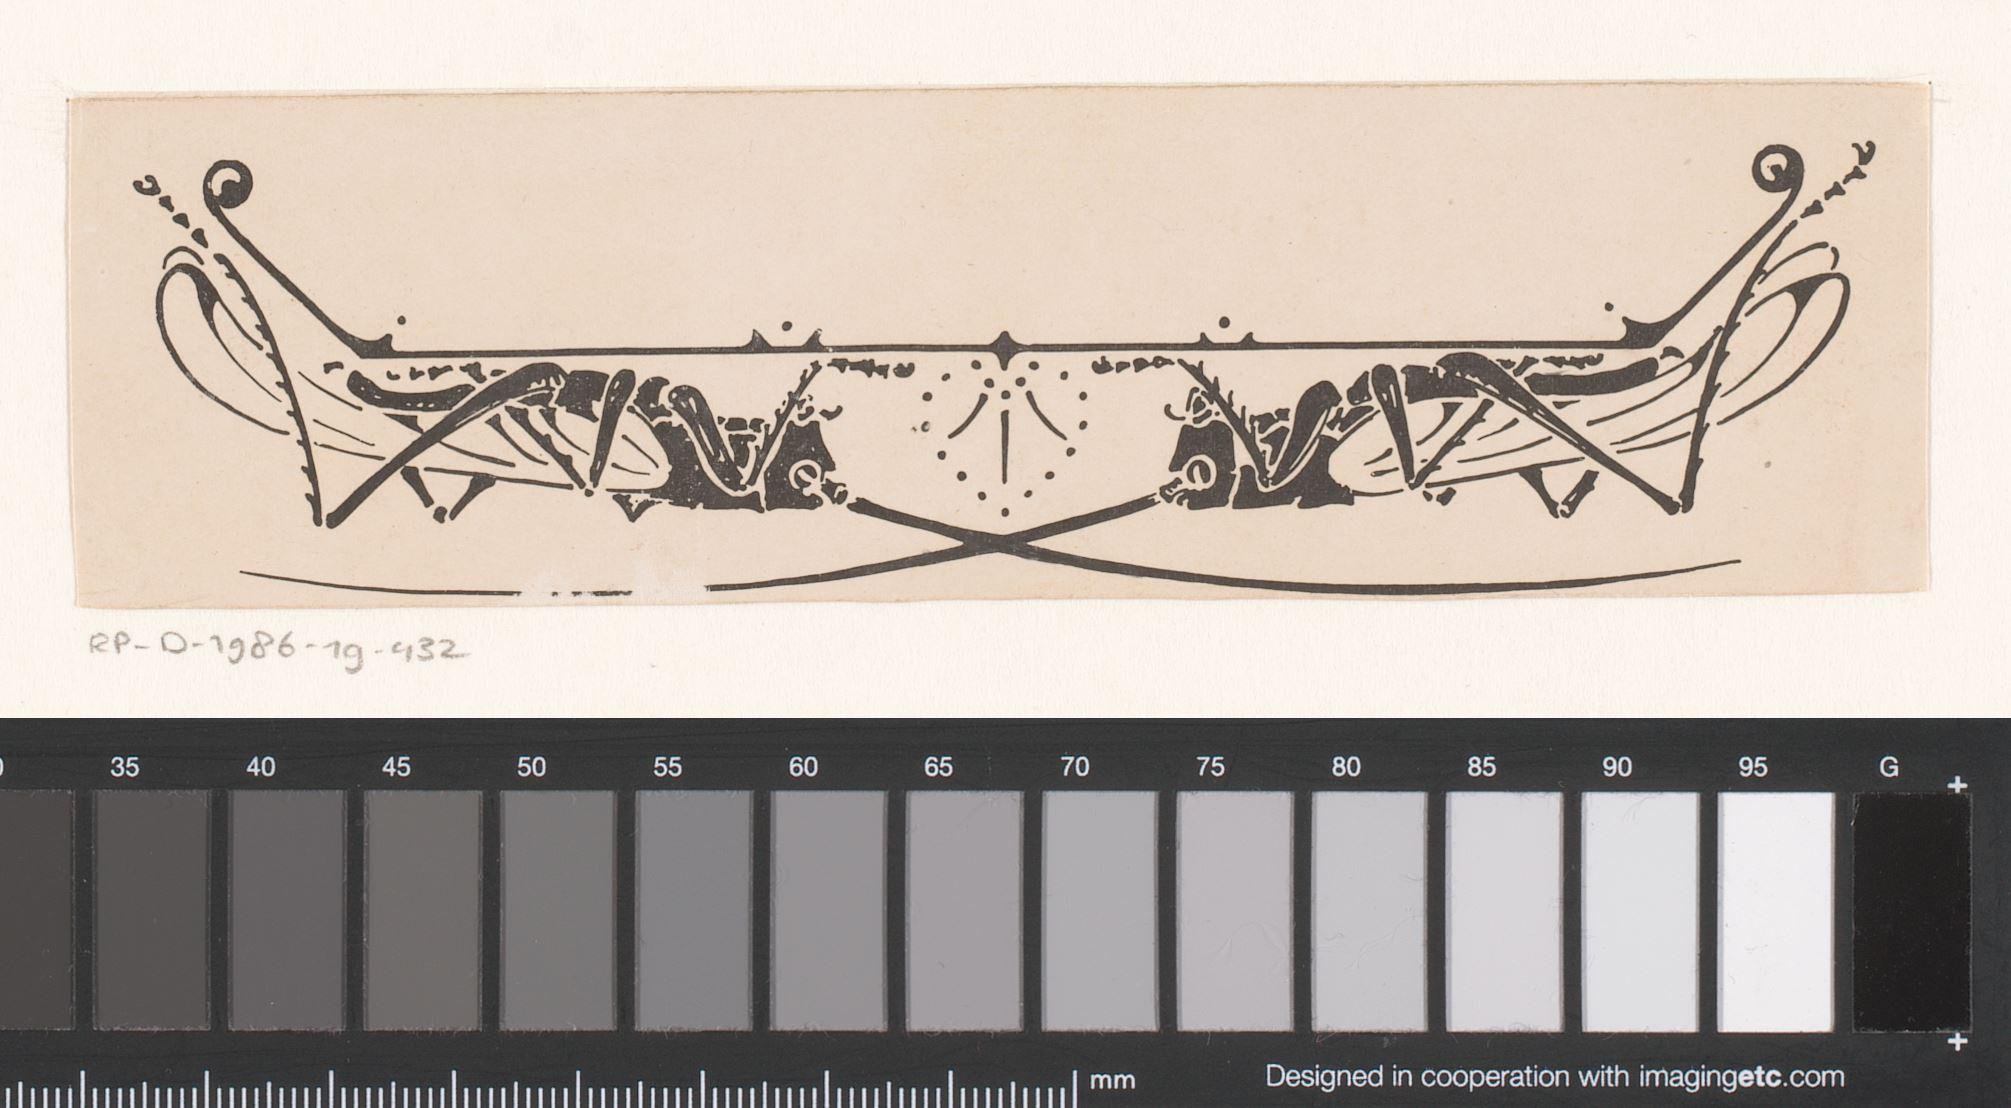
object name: photomechanical print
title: Vignet met twee insecten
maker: reinier willem petrus de vries (1874-1953)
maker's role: draughtsman, print maker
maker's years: 1874-1953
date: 1884-1952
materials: paper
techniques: printing block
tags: ornaments ~ art, insects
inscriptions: collector's mark: ‘R:MVS.’